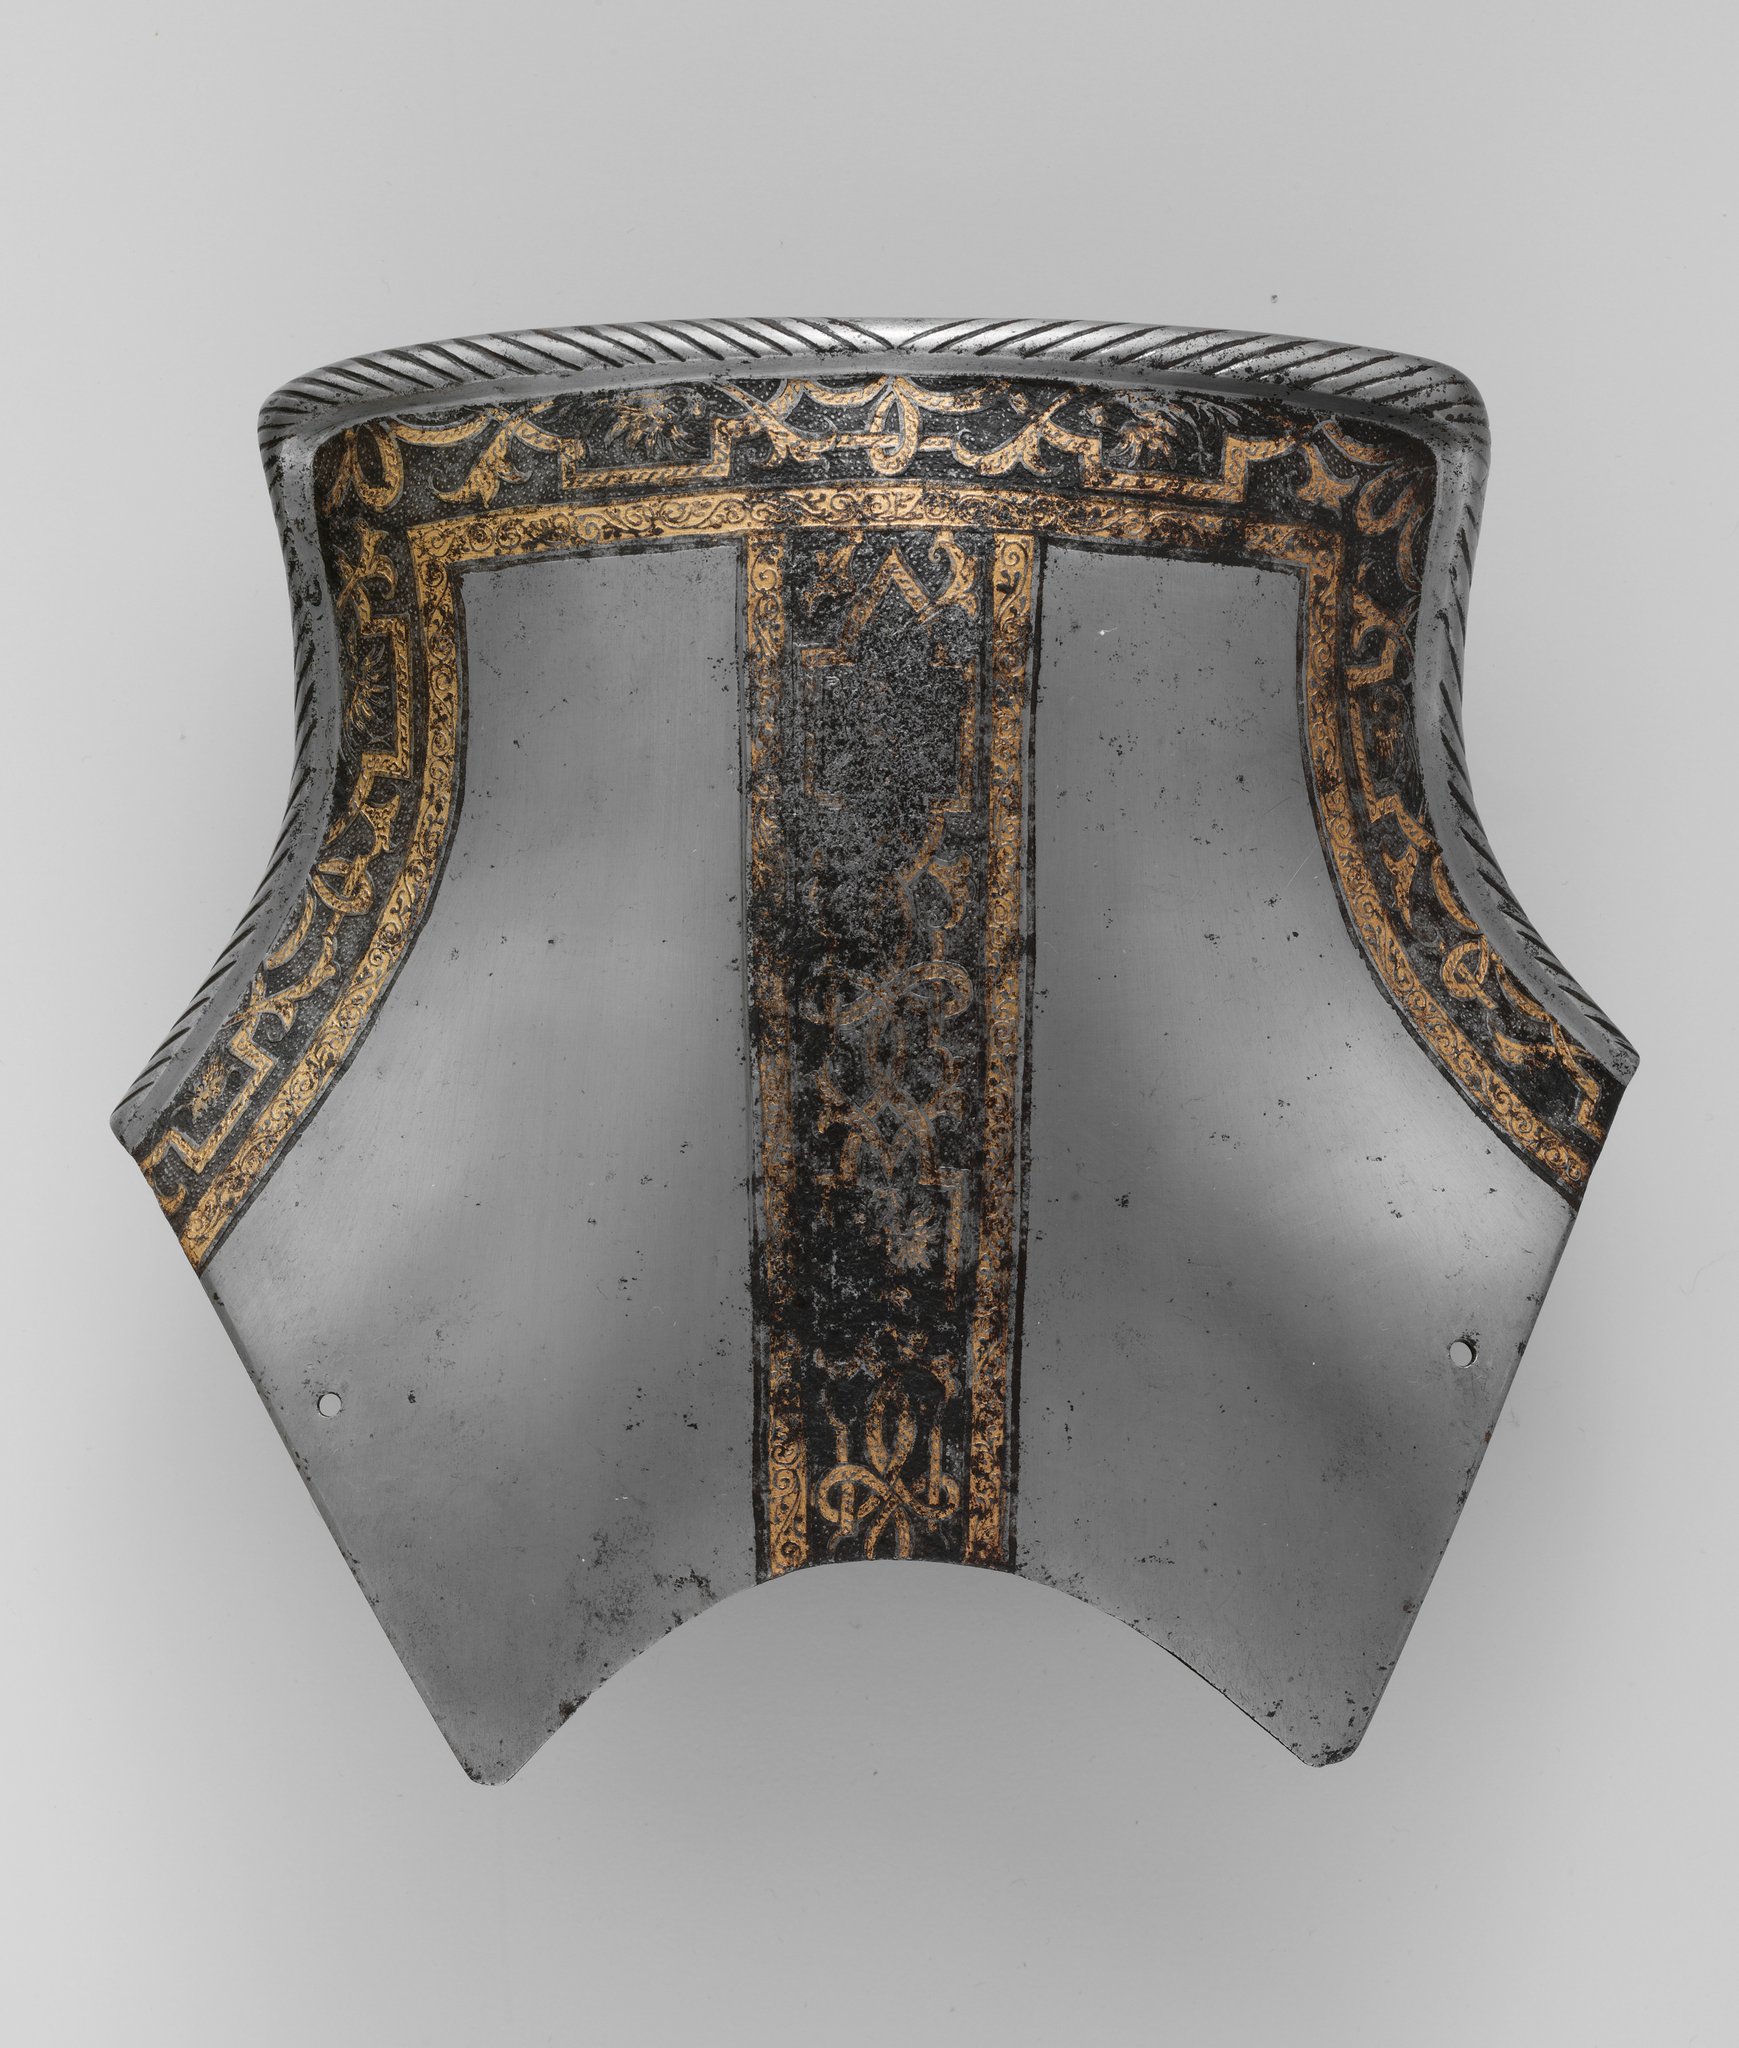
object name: pommel plate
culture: german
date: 1560-1570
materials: gold, steel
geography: germany